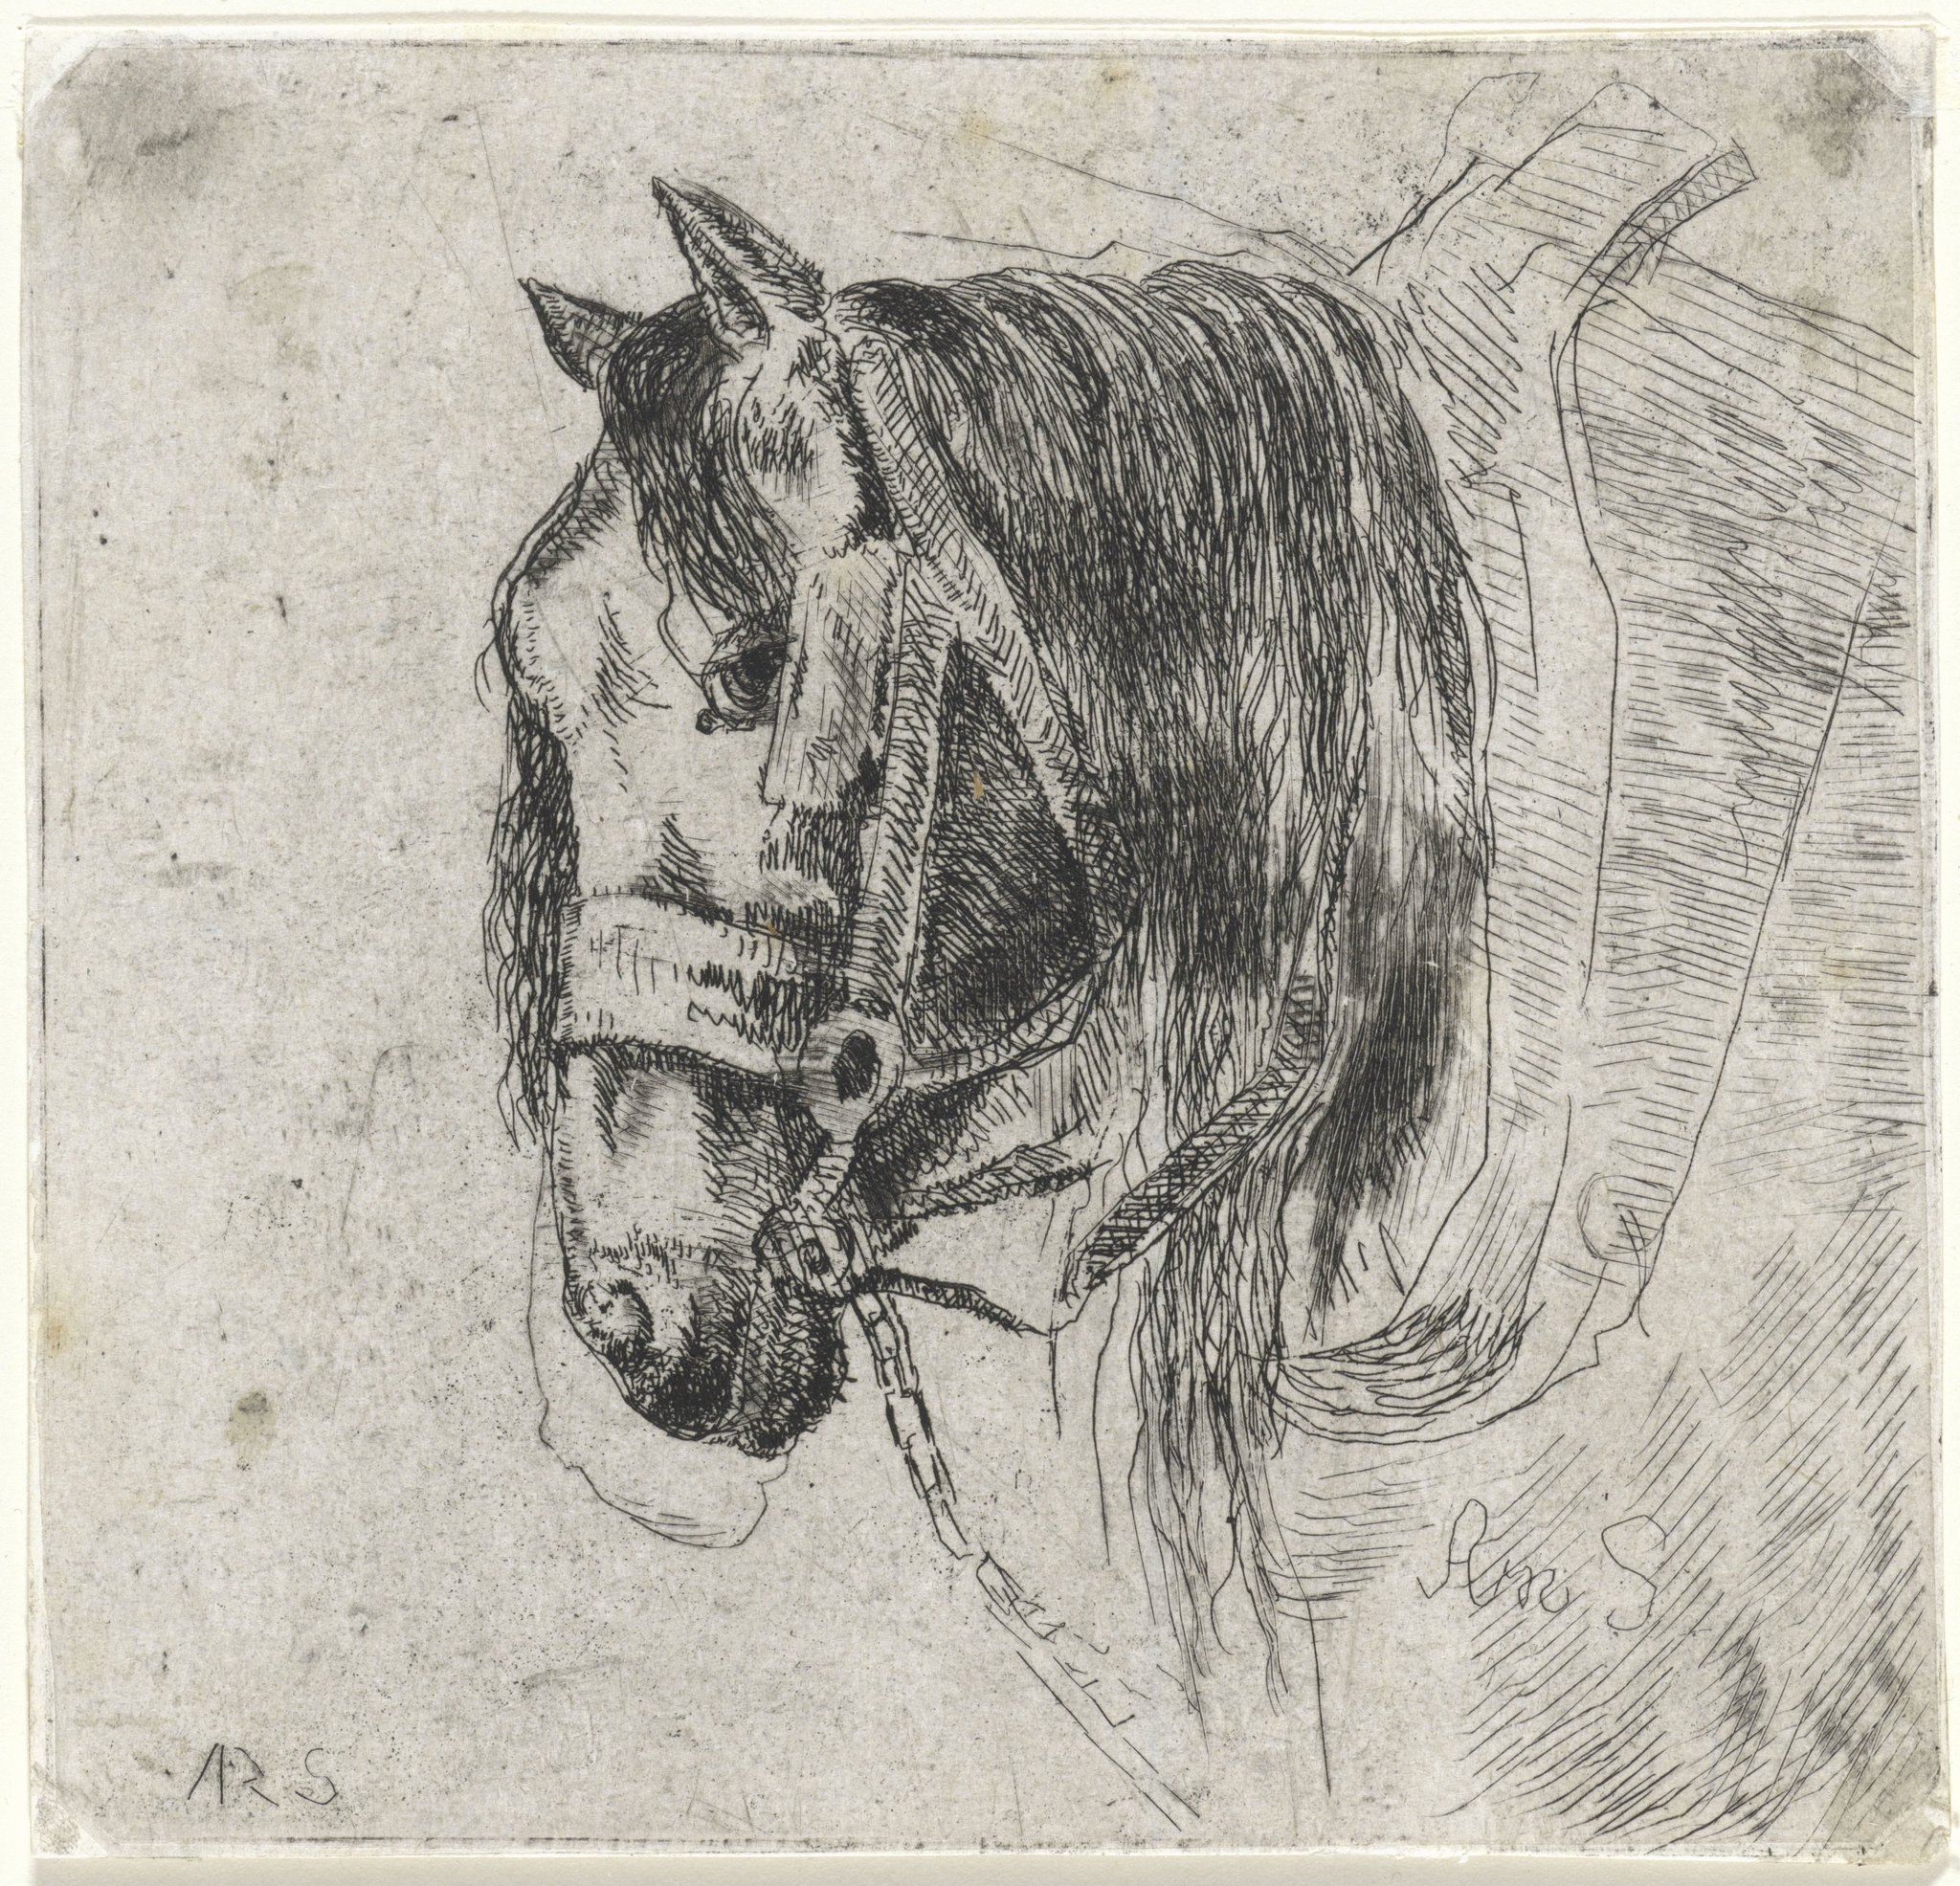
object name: print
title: Paardenhoofd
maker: arnoud schaepkens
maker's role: print maker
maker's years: 1816-1904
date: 1831-1904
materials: paper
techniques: drypoint, etching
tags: horse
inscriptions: collector's mark: Lugt 2228